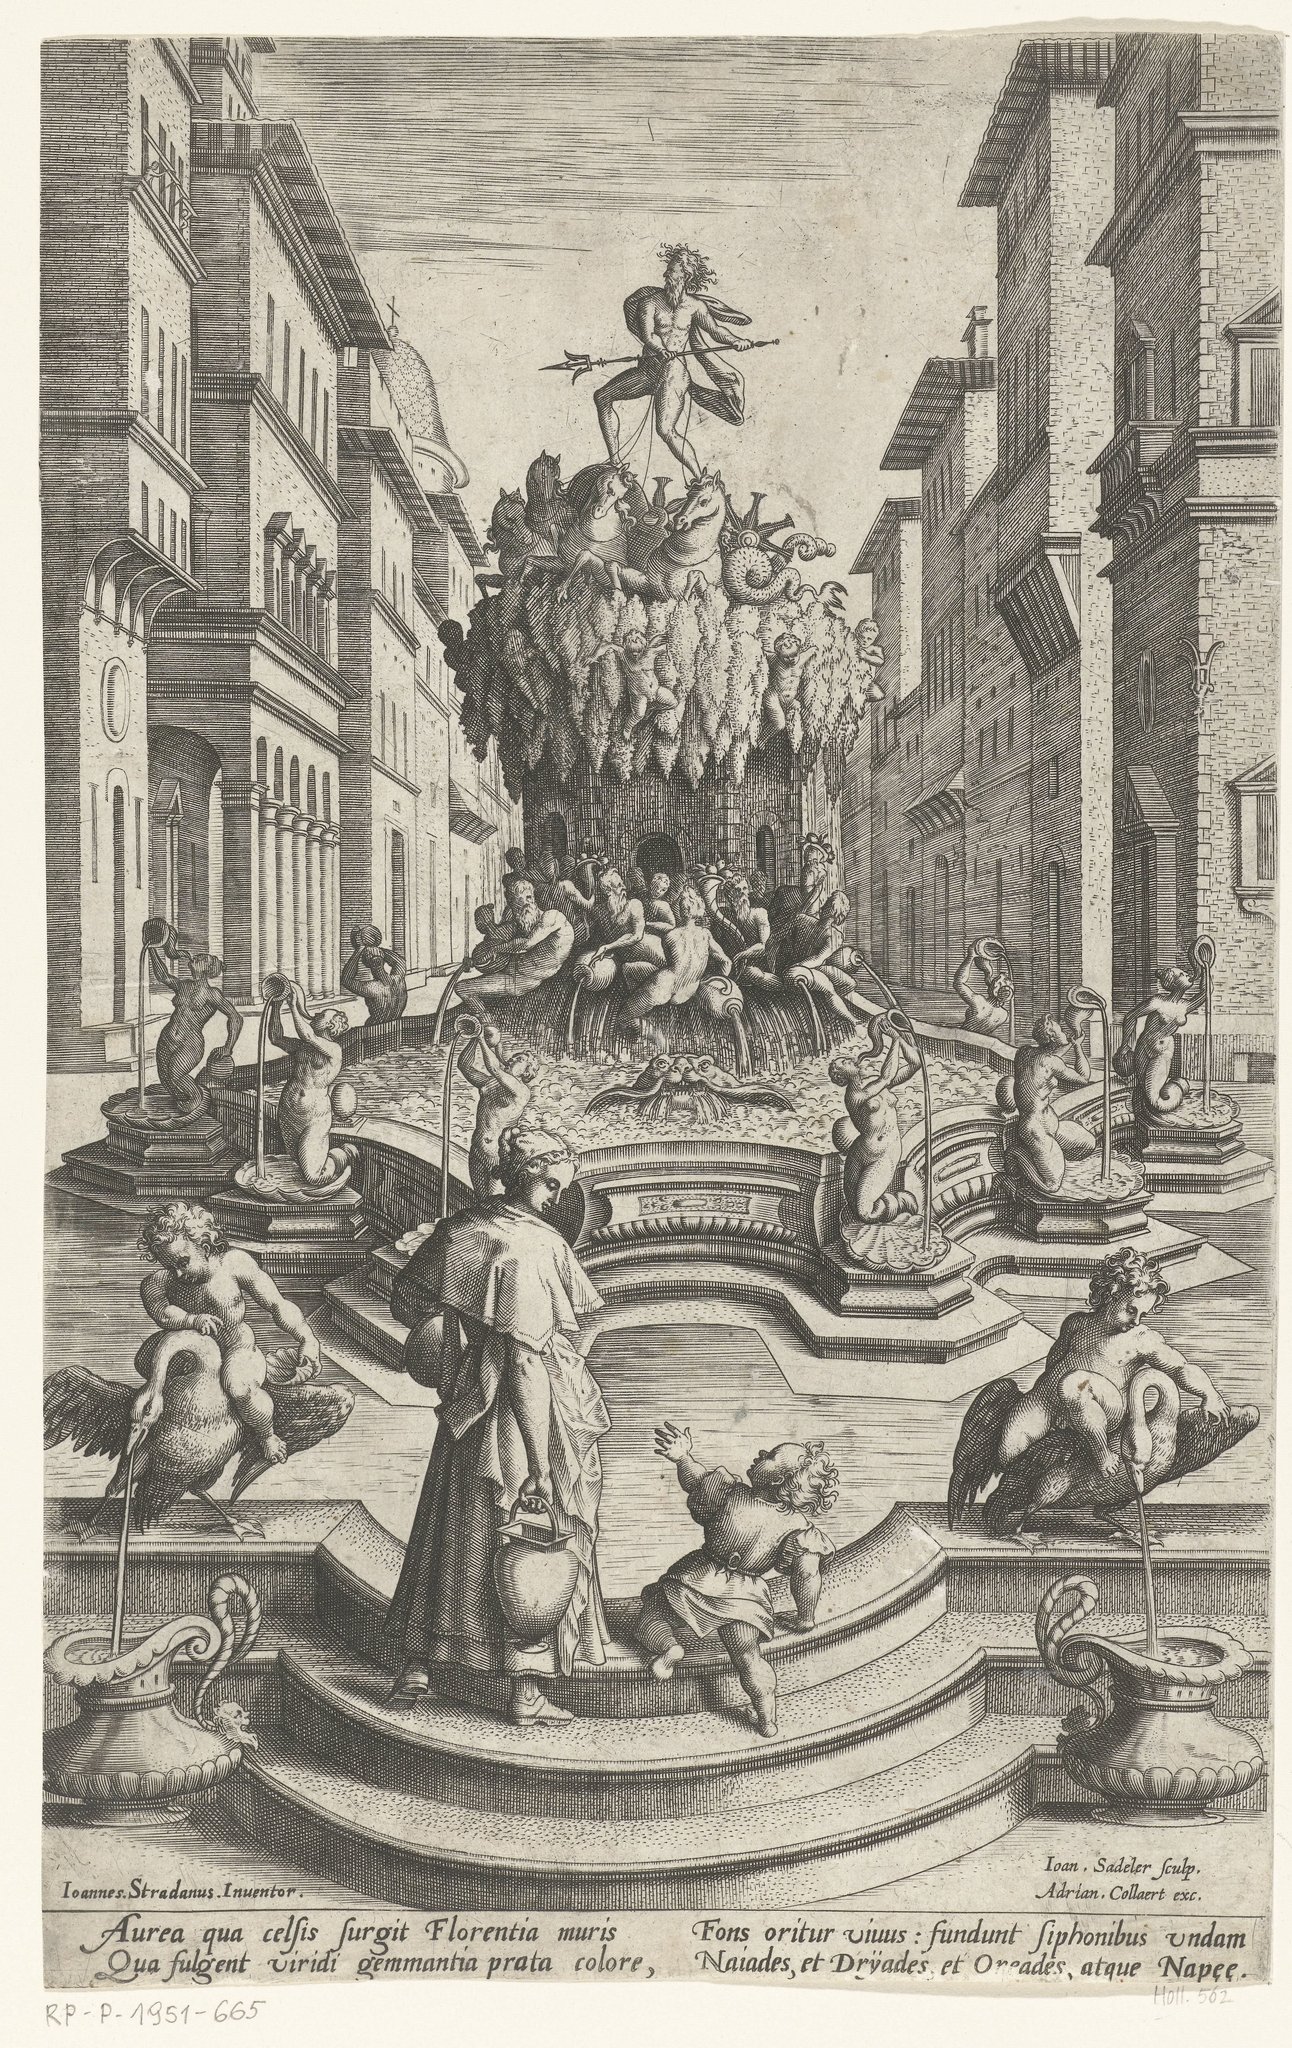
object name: print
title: Neptunusfontein te Florence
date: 1601-1618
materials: paper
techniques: engraving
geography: antwerp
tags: prague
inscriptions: collector's mark: Lugt 2228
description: Een Neptunusfontein, waarschijnlijk die fontein die in Florence werd opgericht ter ere van de intrede van Johanna van Oostenrijk in 1565. Centraal in de fontein rijdt Neptunus op een schelp getrokken door vier zeepaarden. Rondom hem waternimfen. Op de voorgrond twee putti op zwanen. Een vrouw loopt richting de fontein om water te gaan halen.